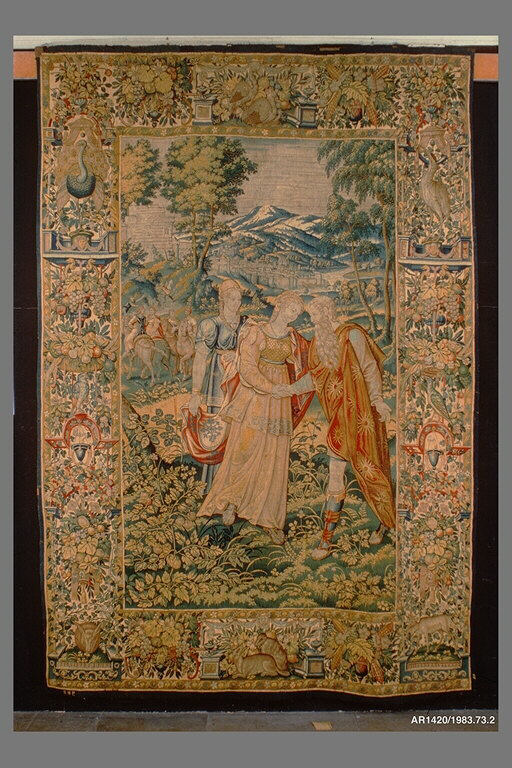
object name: tapestry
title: Rachel Giving Bilhah to Jacob from The Story of Jacob series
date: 1550-1575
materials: silk, wool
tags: men,women,horses,mountains,leaves